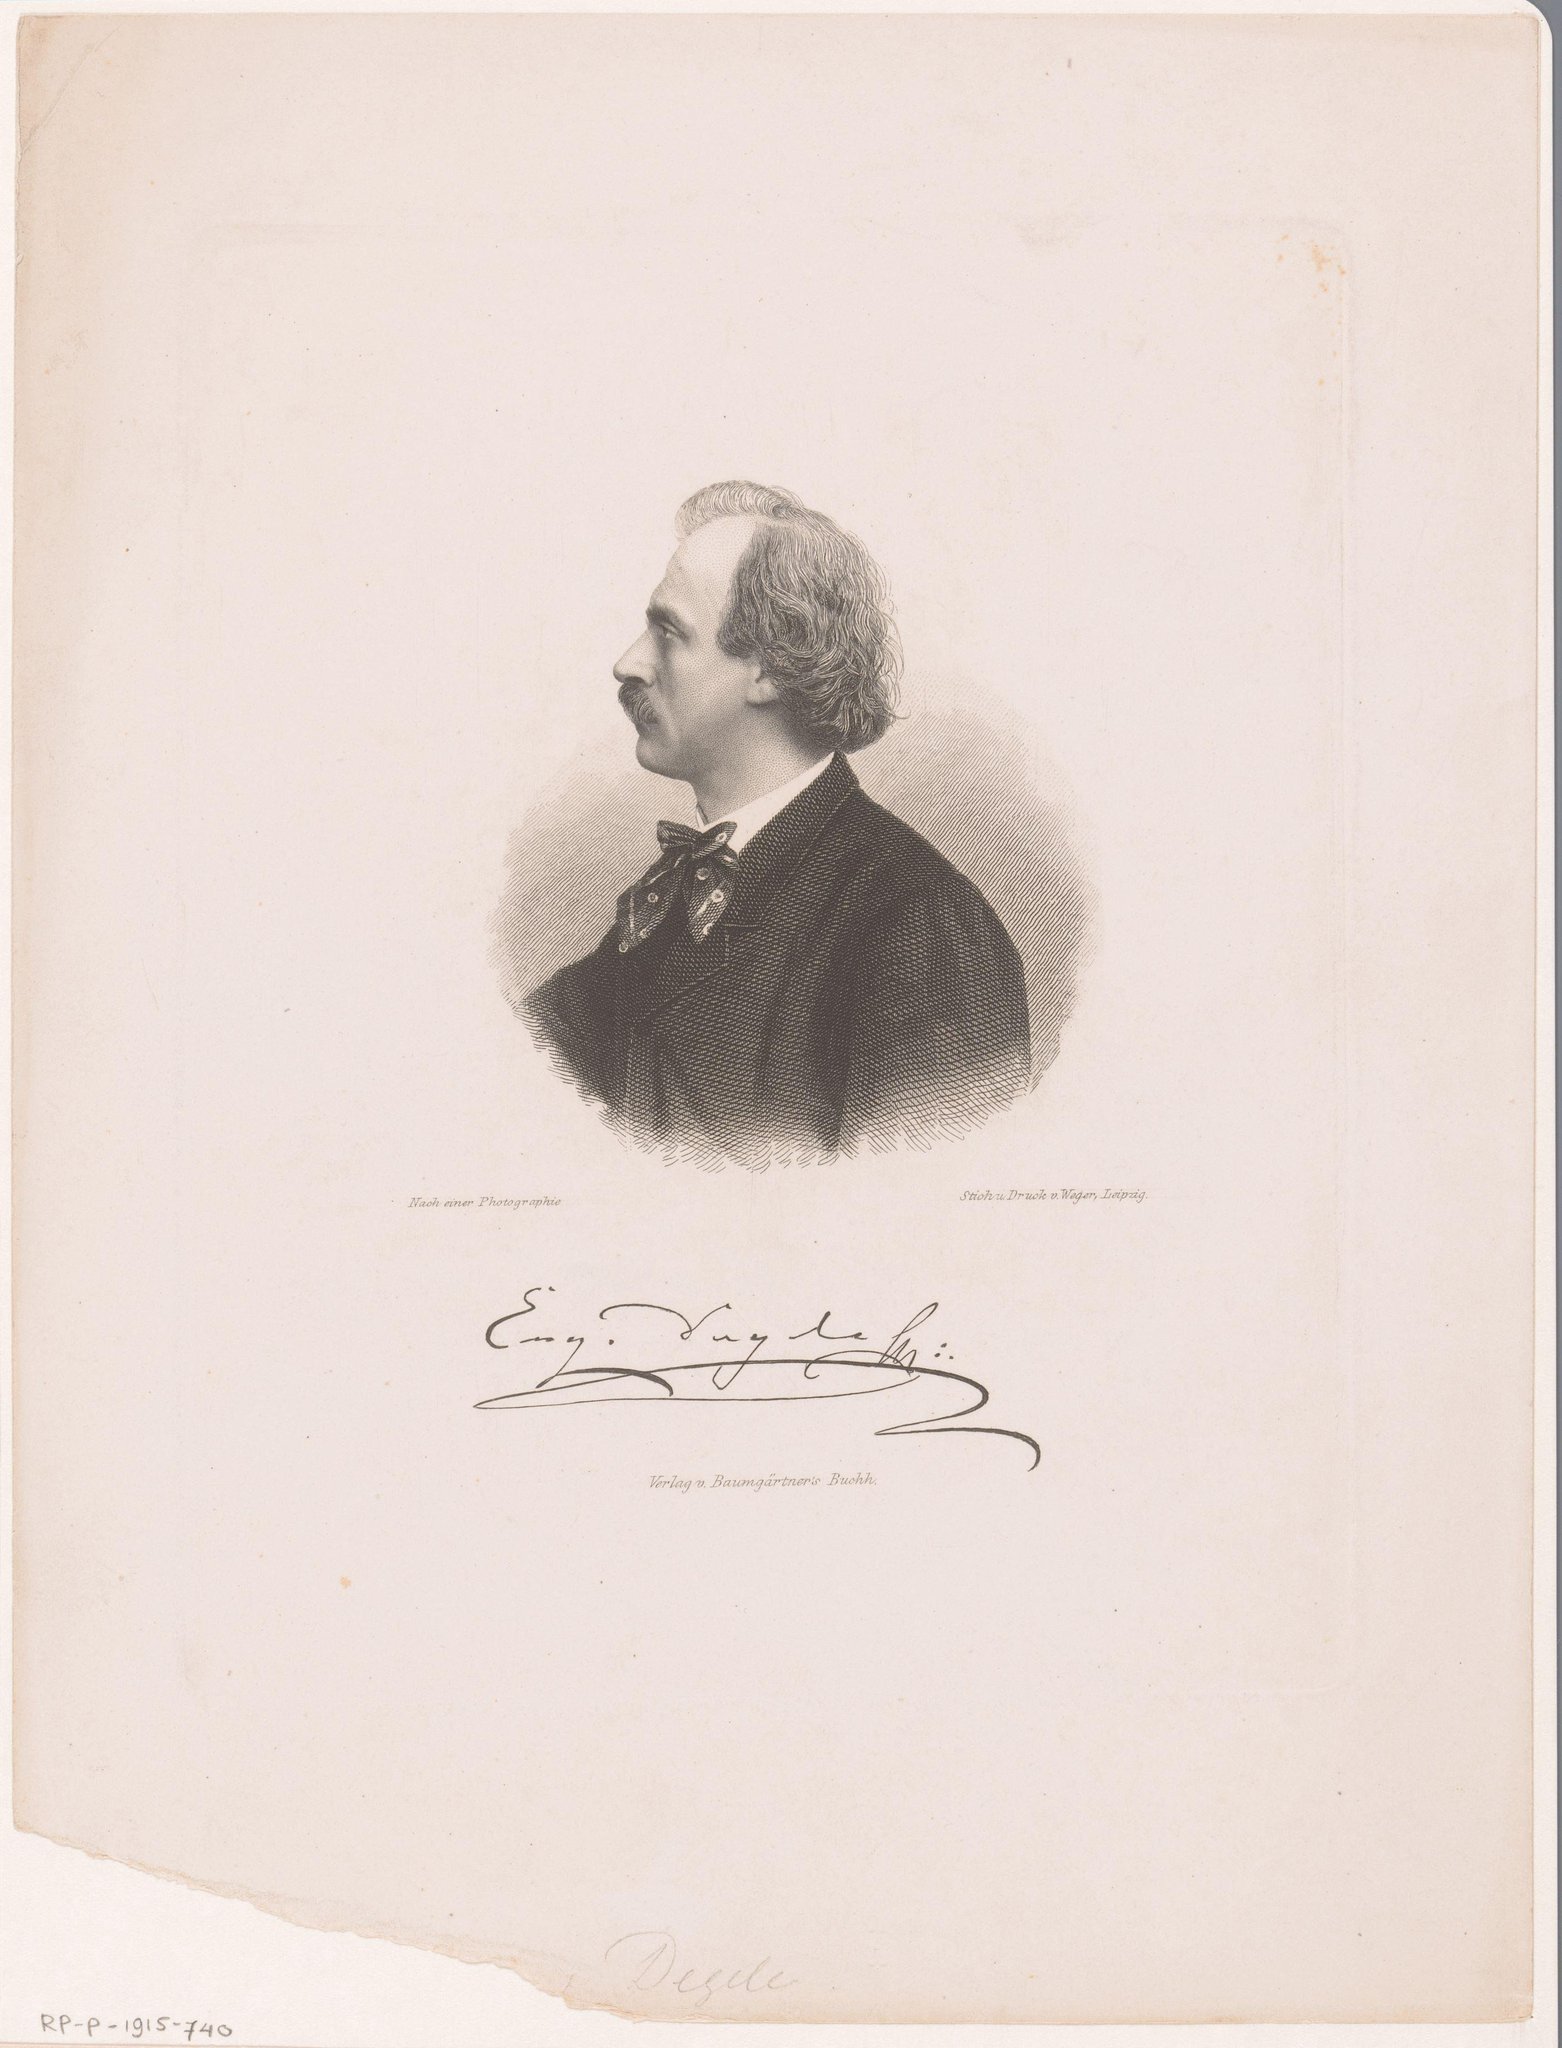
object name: print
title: Portret van Eugen Degele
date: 1870-1892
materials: paper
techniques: engraving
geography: leipzig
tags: historical persons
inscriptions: collector's mark: Lugt 2228